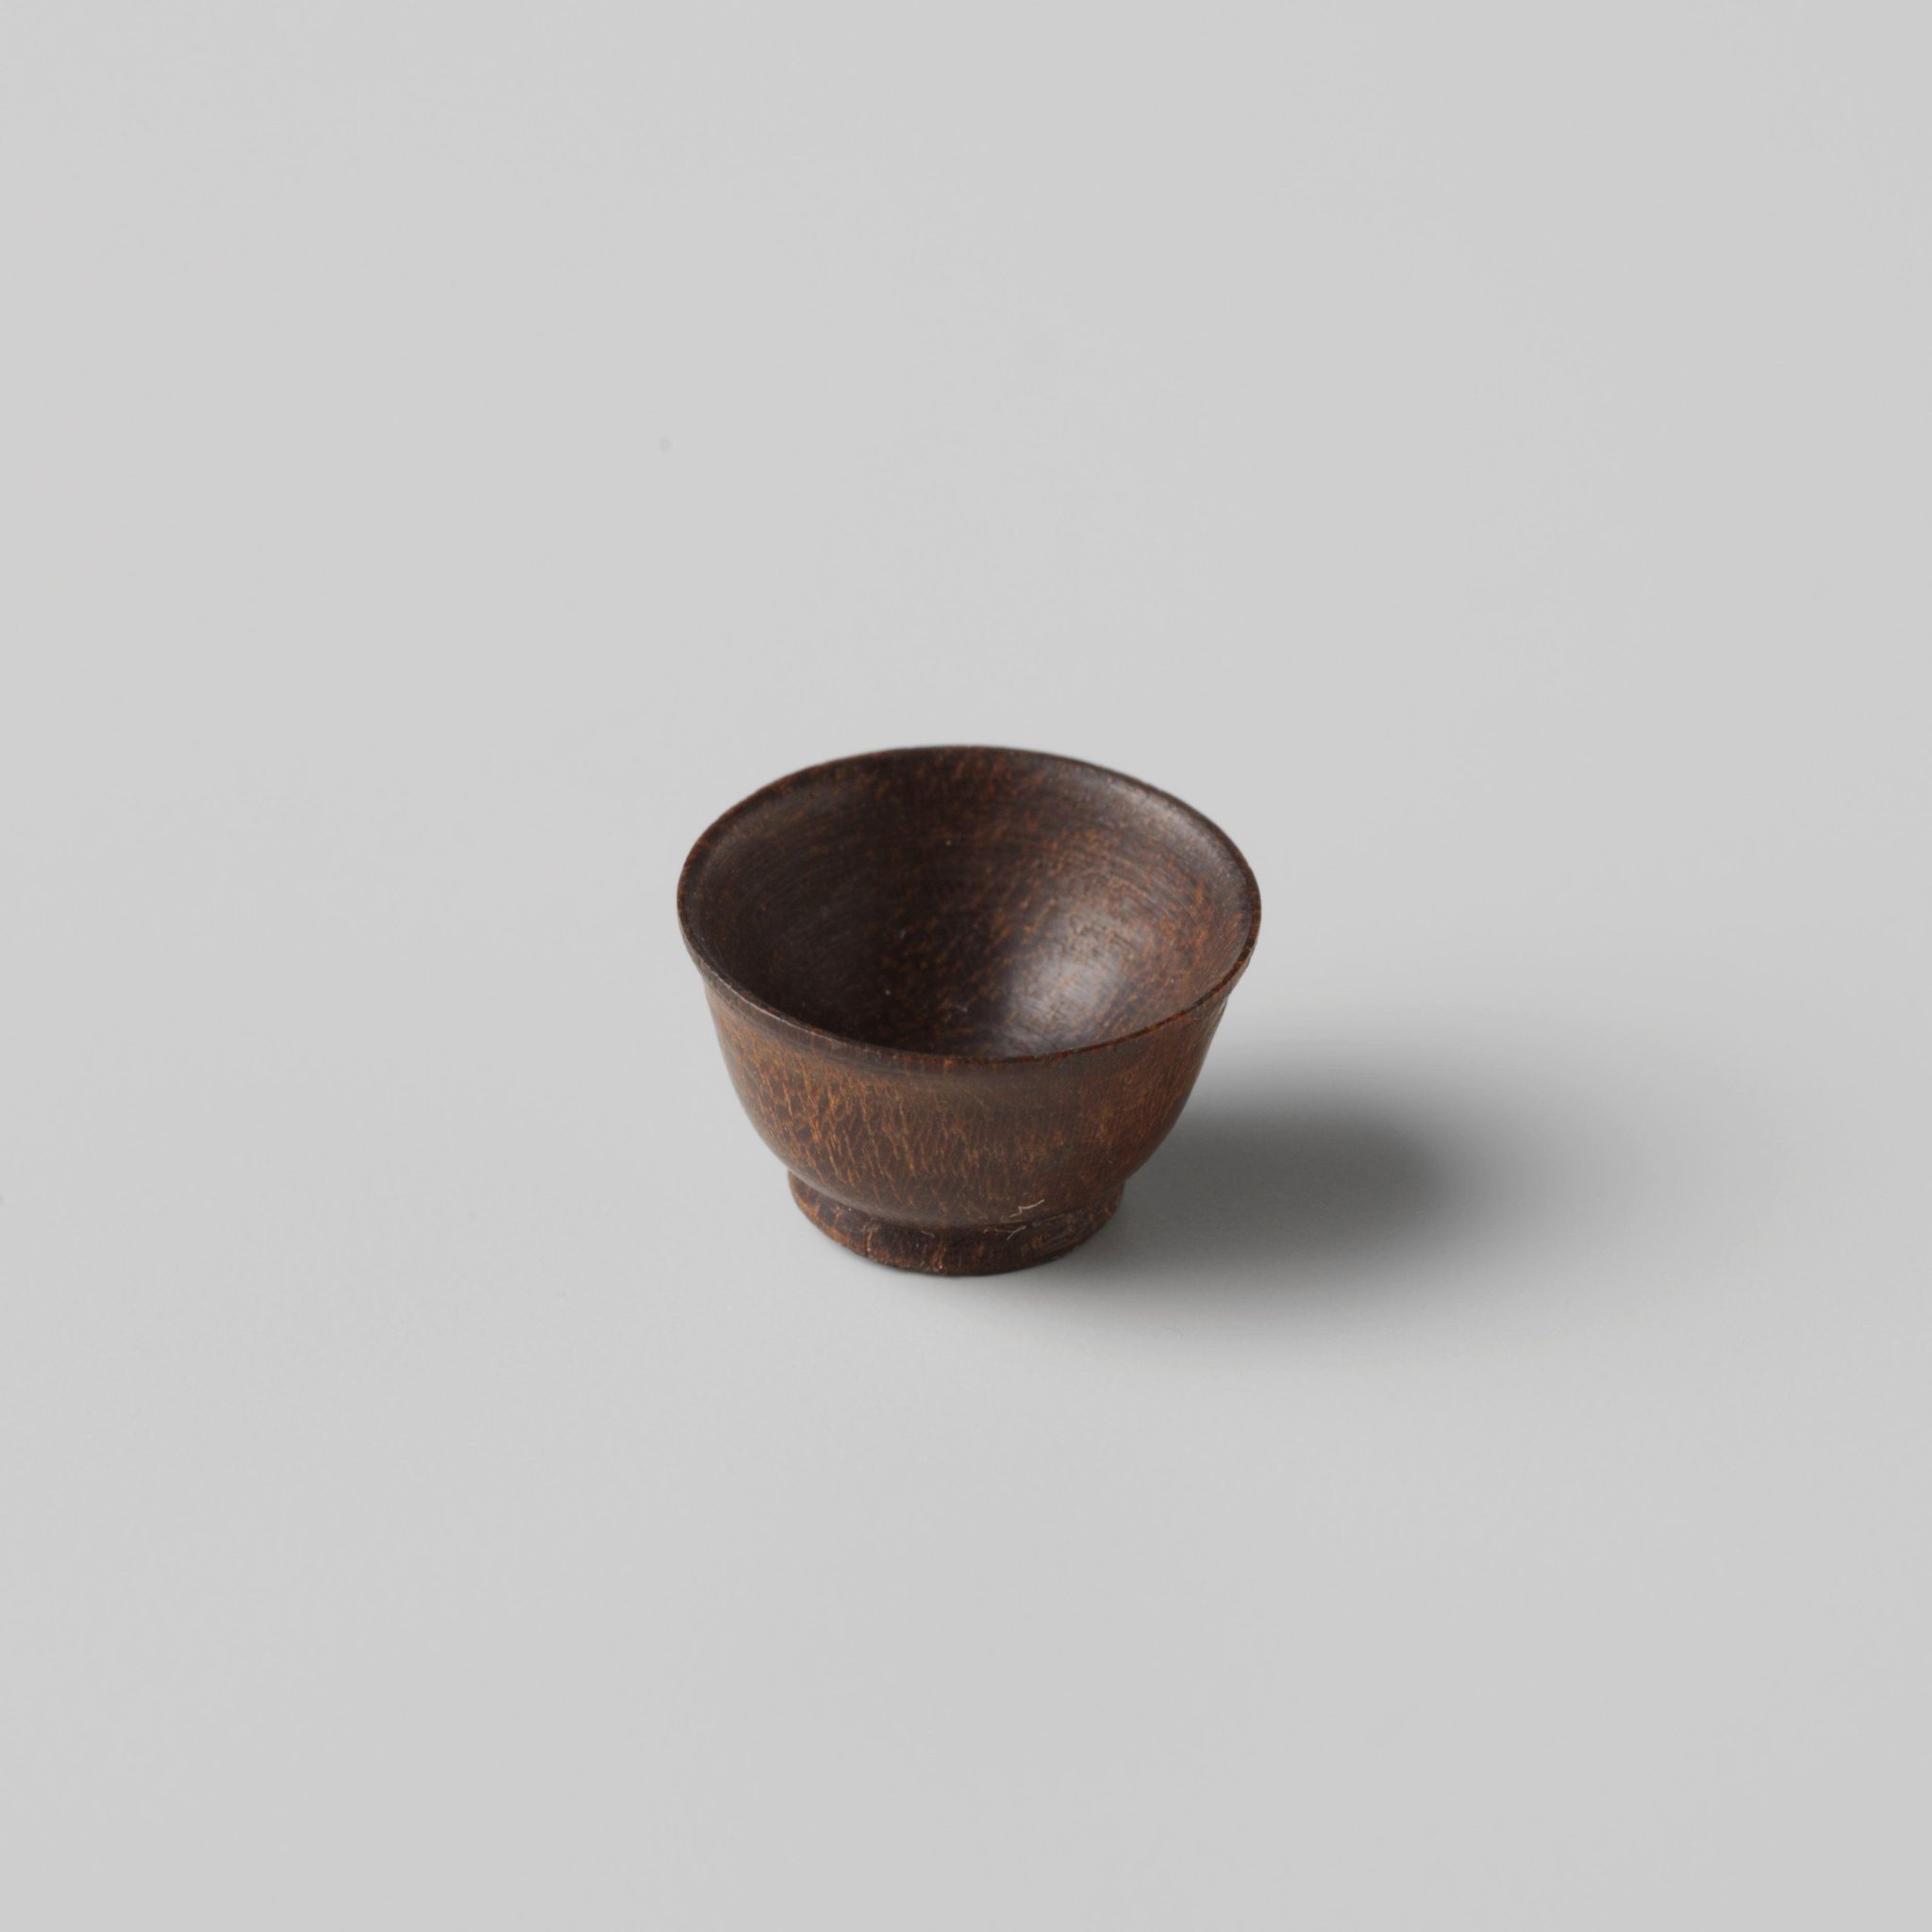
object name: tea cup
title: Theekop van gedraaid hout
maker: Anonymous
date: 1800-1899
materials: wood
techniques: tropisch hardhout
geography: england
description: Vier koppen gedraaid van een donkere hardhoutsoort.